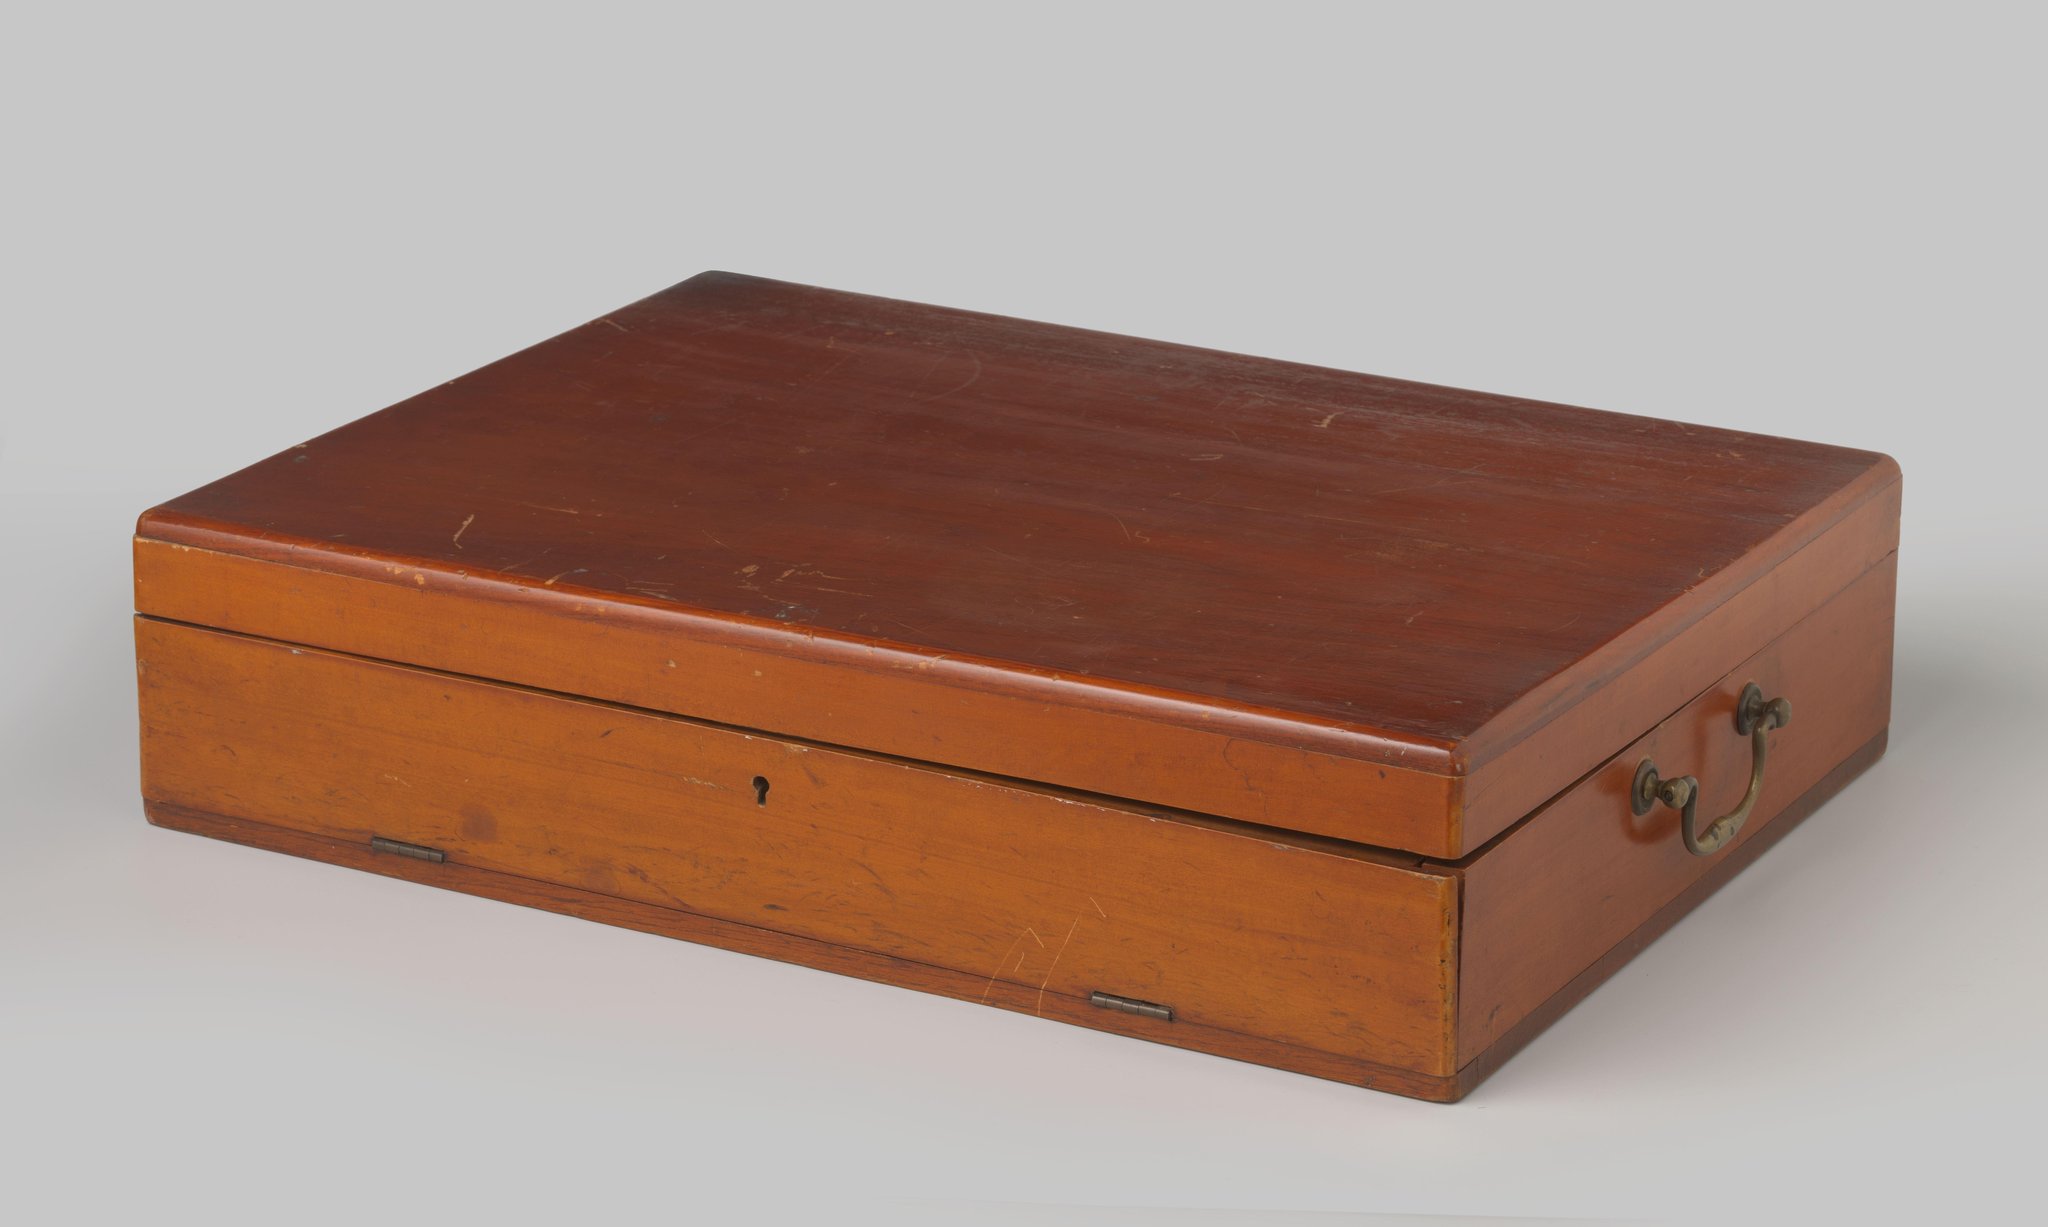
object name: chest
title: Kist bij fotoalbum over de suikerindustrie en topografie van Java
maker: c. schlieper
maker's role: smid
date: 1876-1884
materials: brass, velvet, wood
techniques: cutting, screwed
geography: batavia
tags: utrecht, the hague, surabaya, java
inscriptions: mark: ‘VAN ARCKEN & Co. kONINKLIJKE FABRIEK VAN GOUD ZILVER EN DIAMANTEN ZAKEN BATAVIA GENEVE - LONDEN - PARIJS’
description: Houten kist behorende bij fotoalbum, met aan beide zijden handvaten van messing. De kist scharniert aan de achterzijde en onder aan de voorzijde. De binnenzijde heeft een gewatteerde paarsfluwelen bekleding (beschadigd), waarop etiket geplakt. De kist sluit met een slot midden aan de voorzijde. De sleutel ontbreekt. Behoort bij het fotoalbum door de Soerabayasche Vereeniging van Suikerfabrikanten aangeboden aan Frederik Beyerinck, resident van Soerabaja.